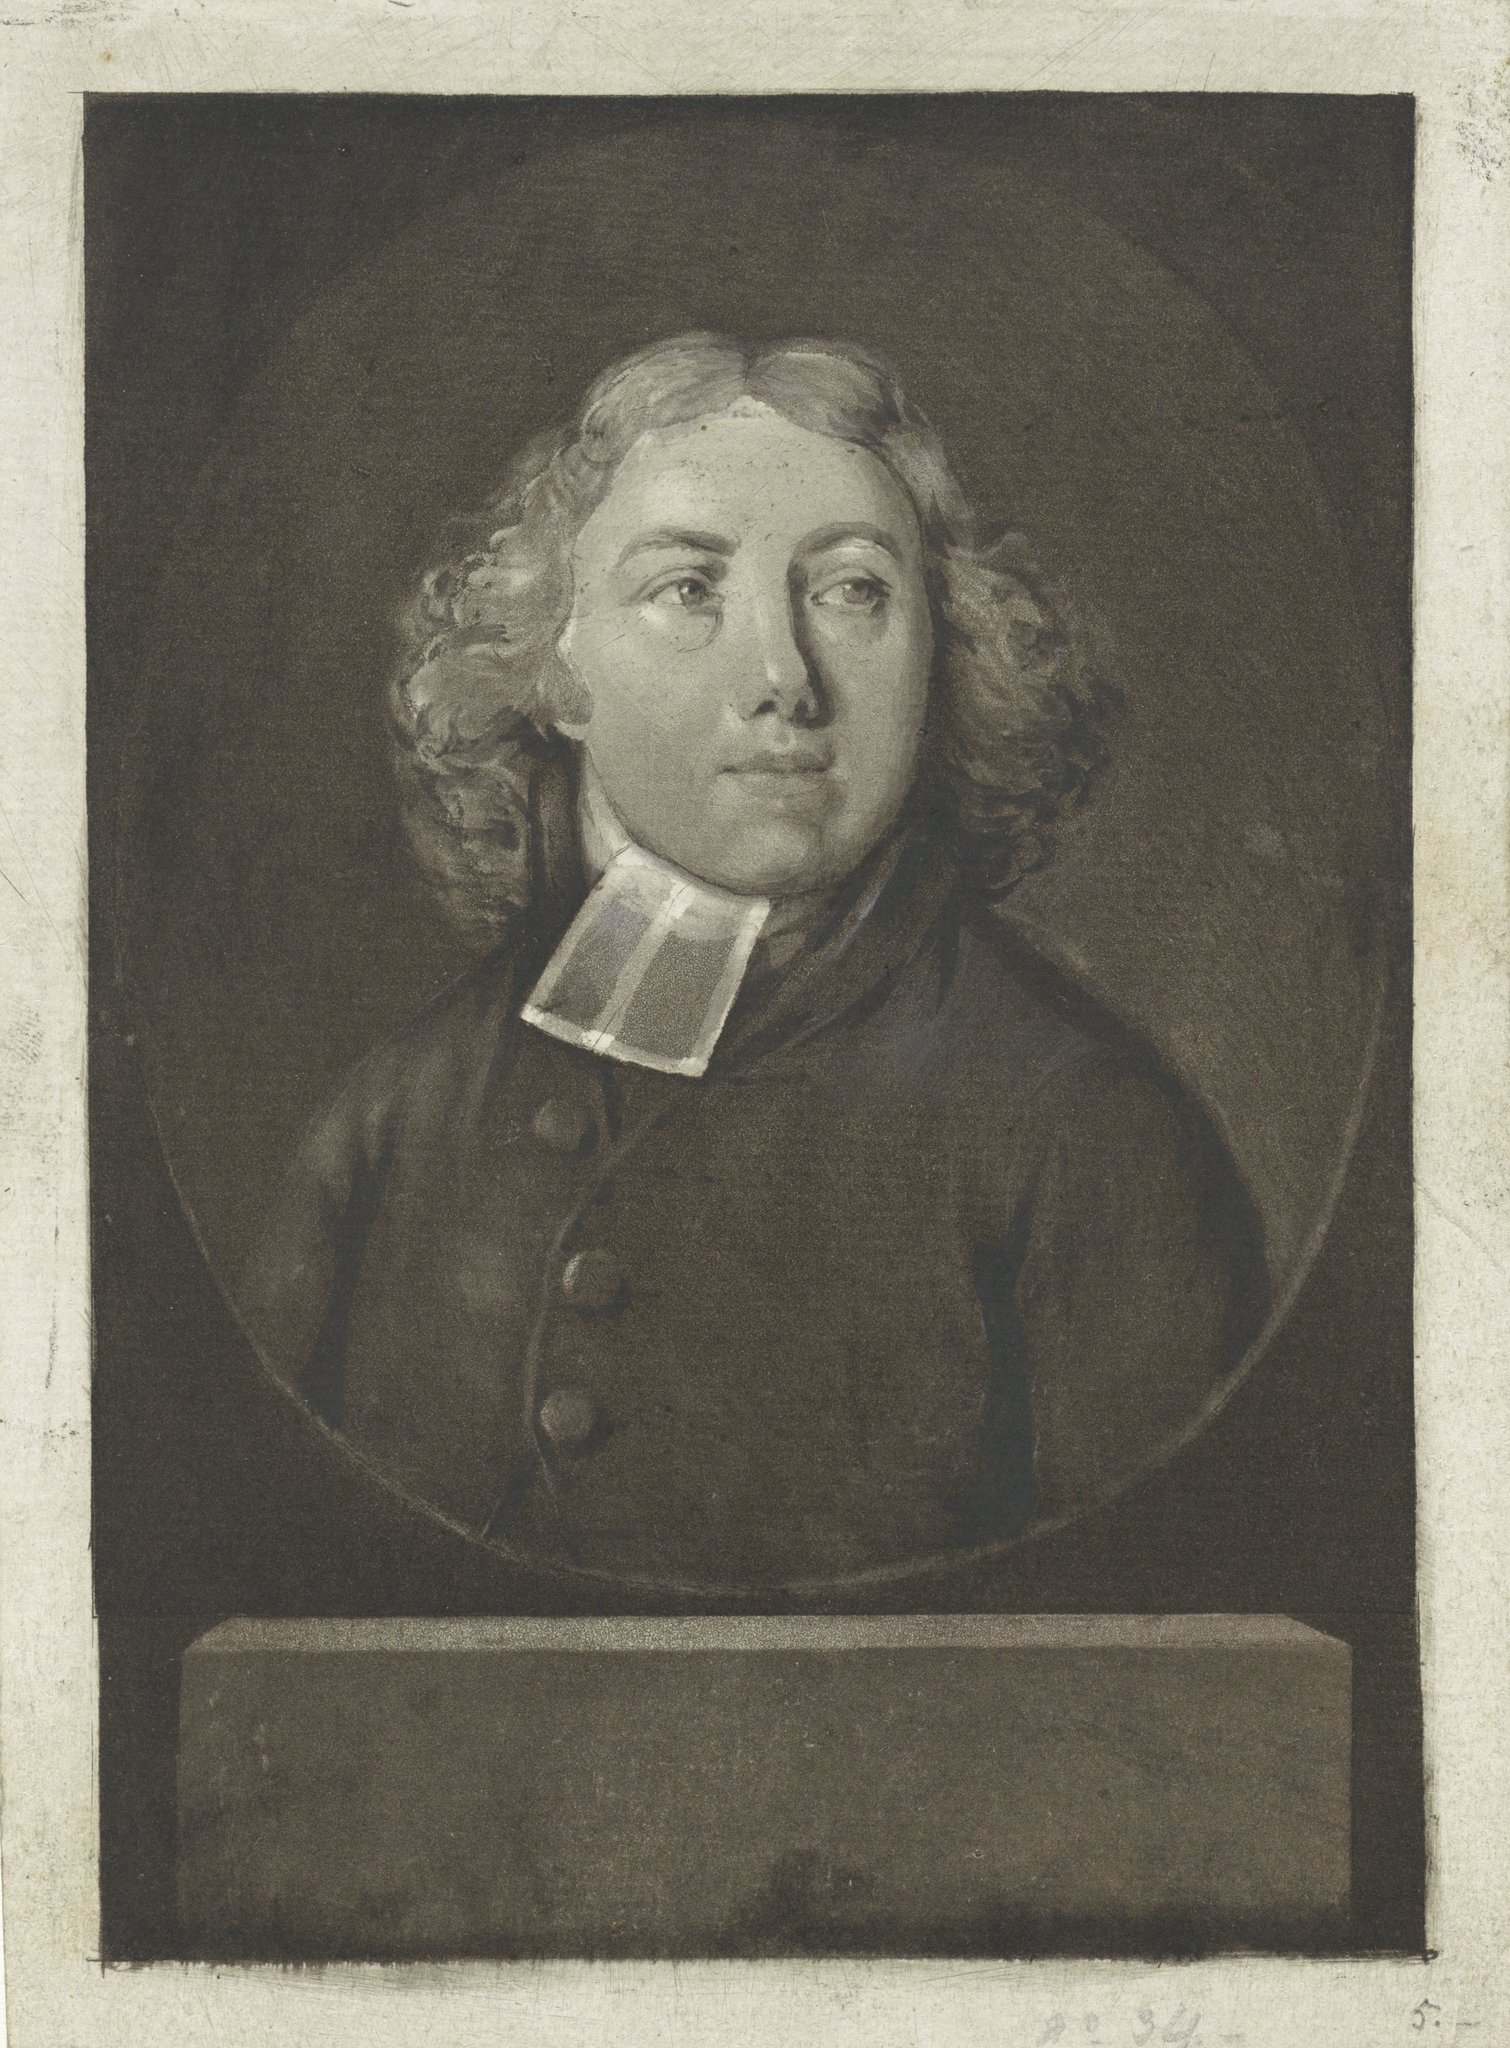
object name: print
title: Portret van een predikant, mogelijk Jacobus Groeneveld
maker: charles howard hodges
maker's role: draughtsman, painter, print maker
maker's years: 1764-1837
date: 1788-1837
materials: paper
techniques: brush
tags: jacobus groeneveld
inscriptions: collector's mark: Lugt 2228